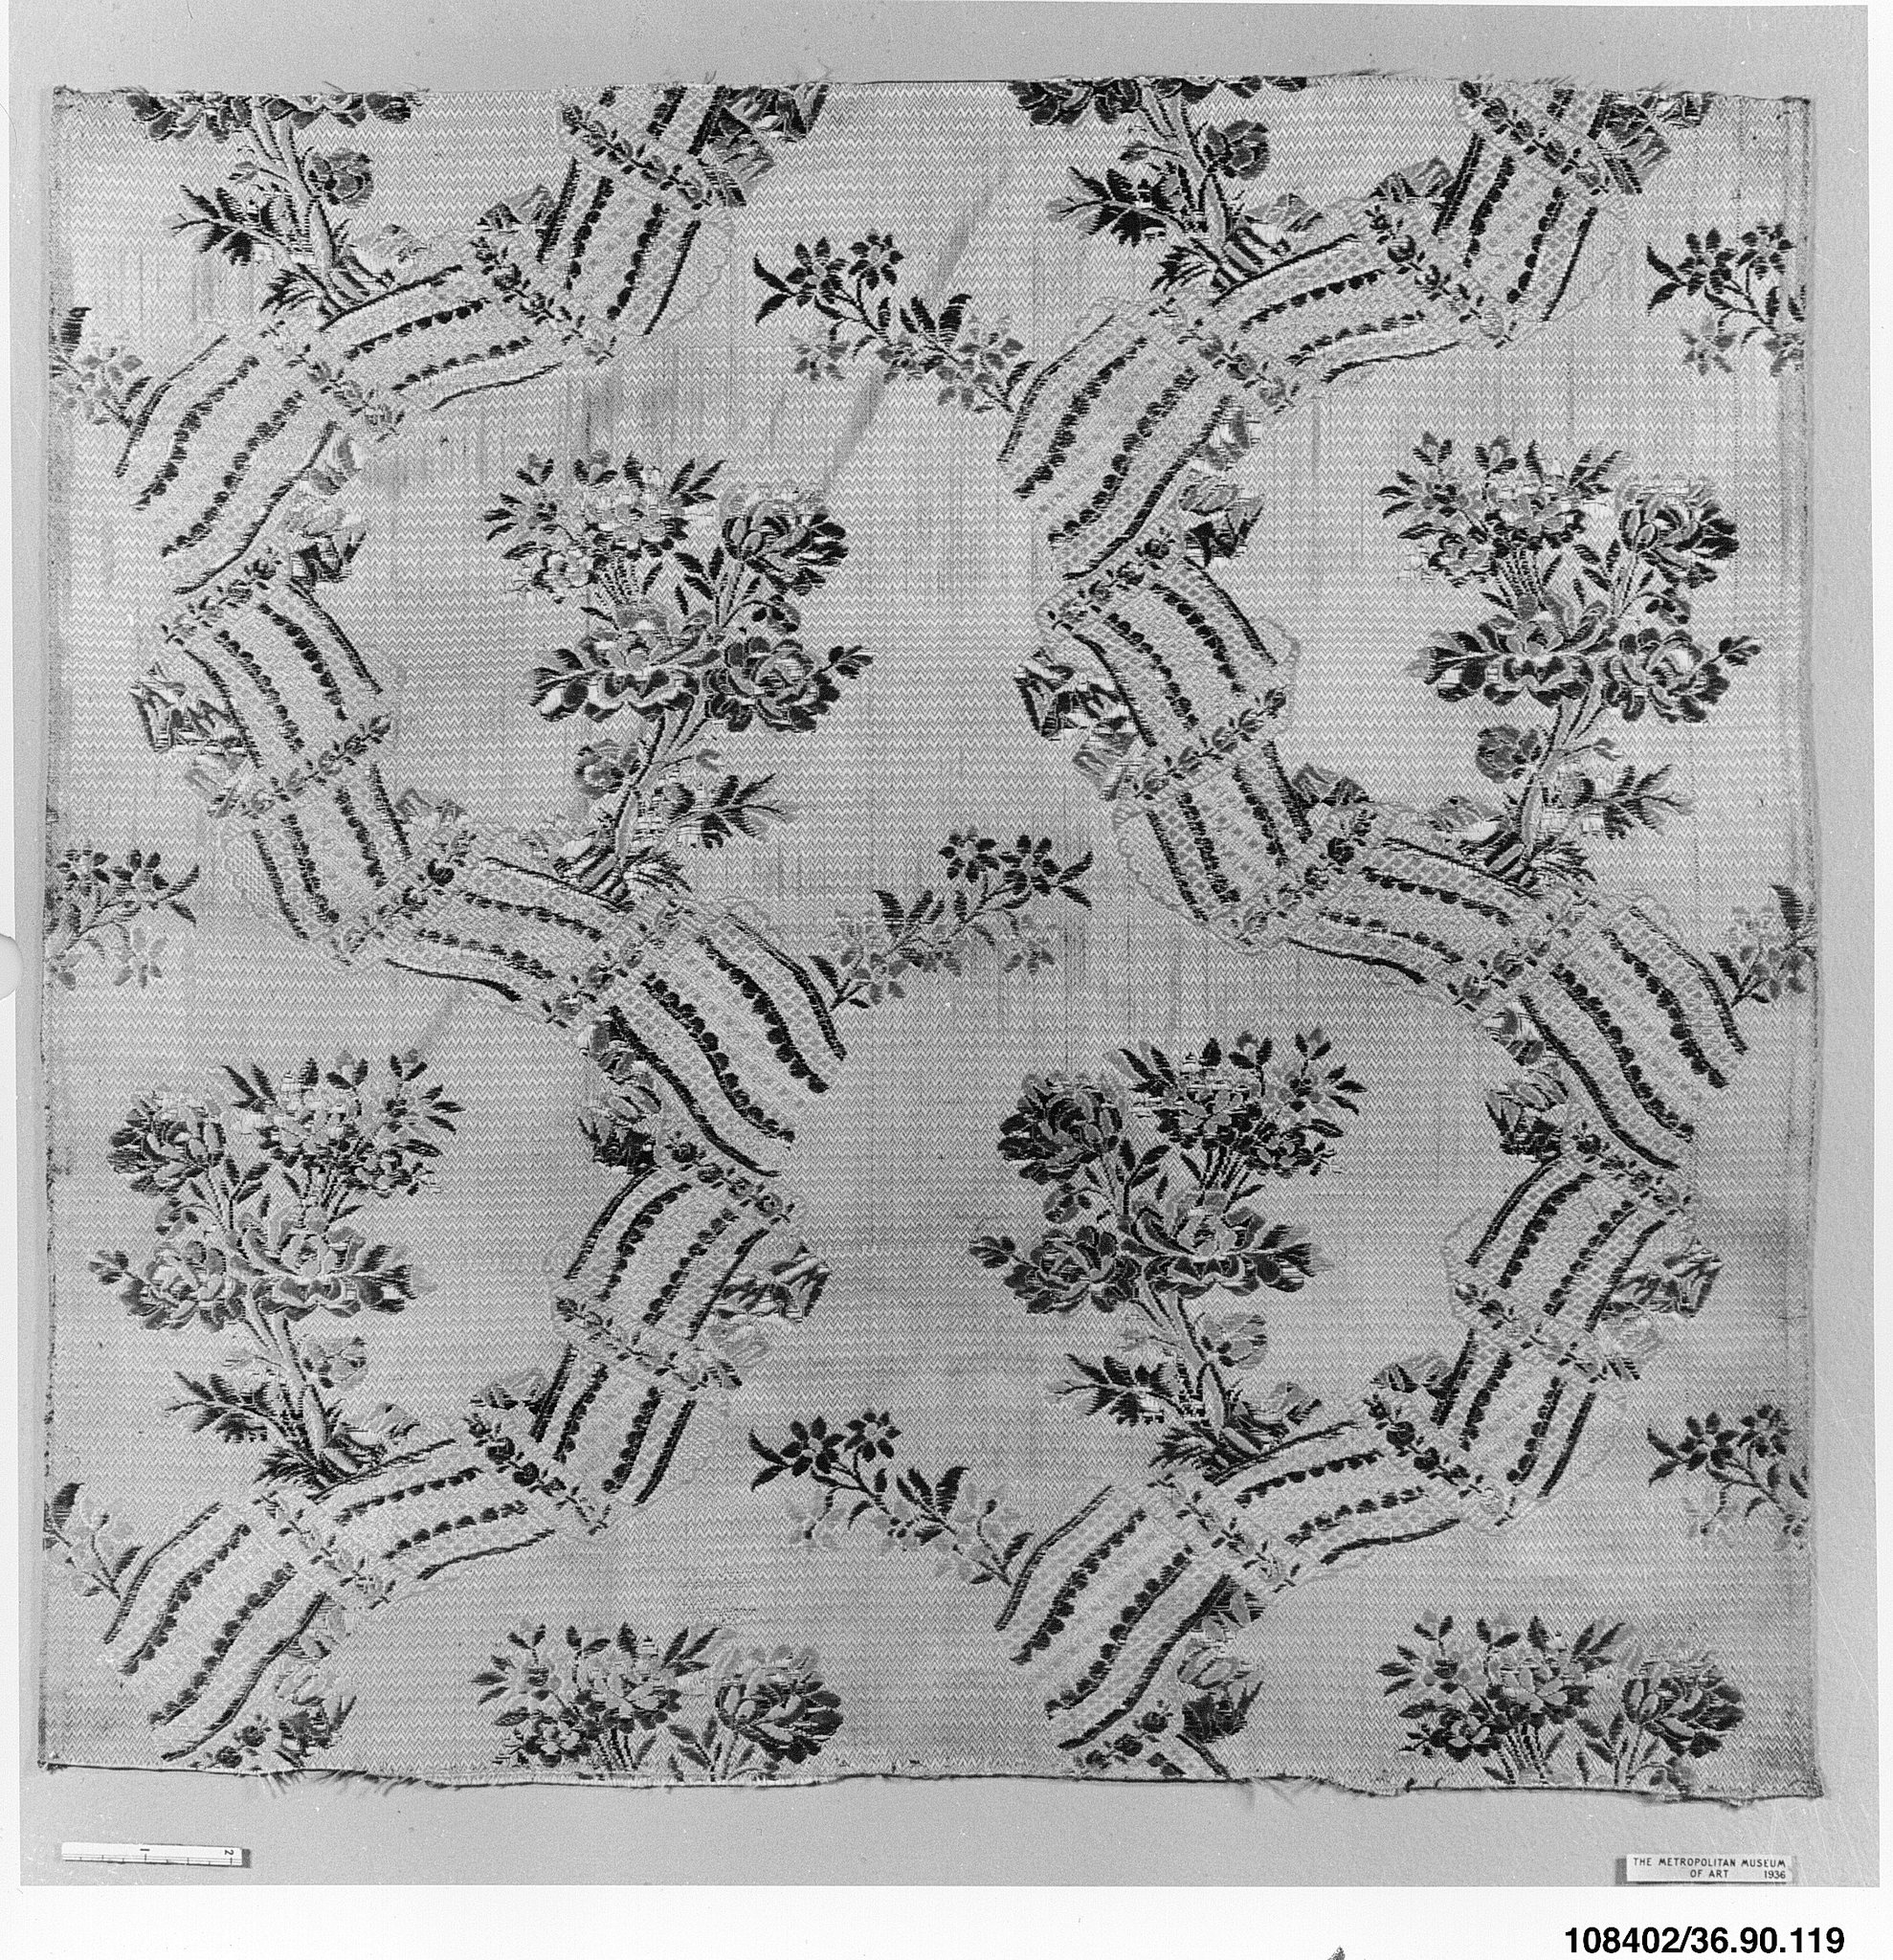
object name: piece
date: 1760-1770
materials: silk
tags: flowers,leaves